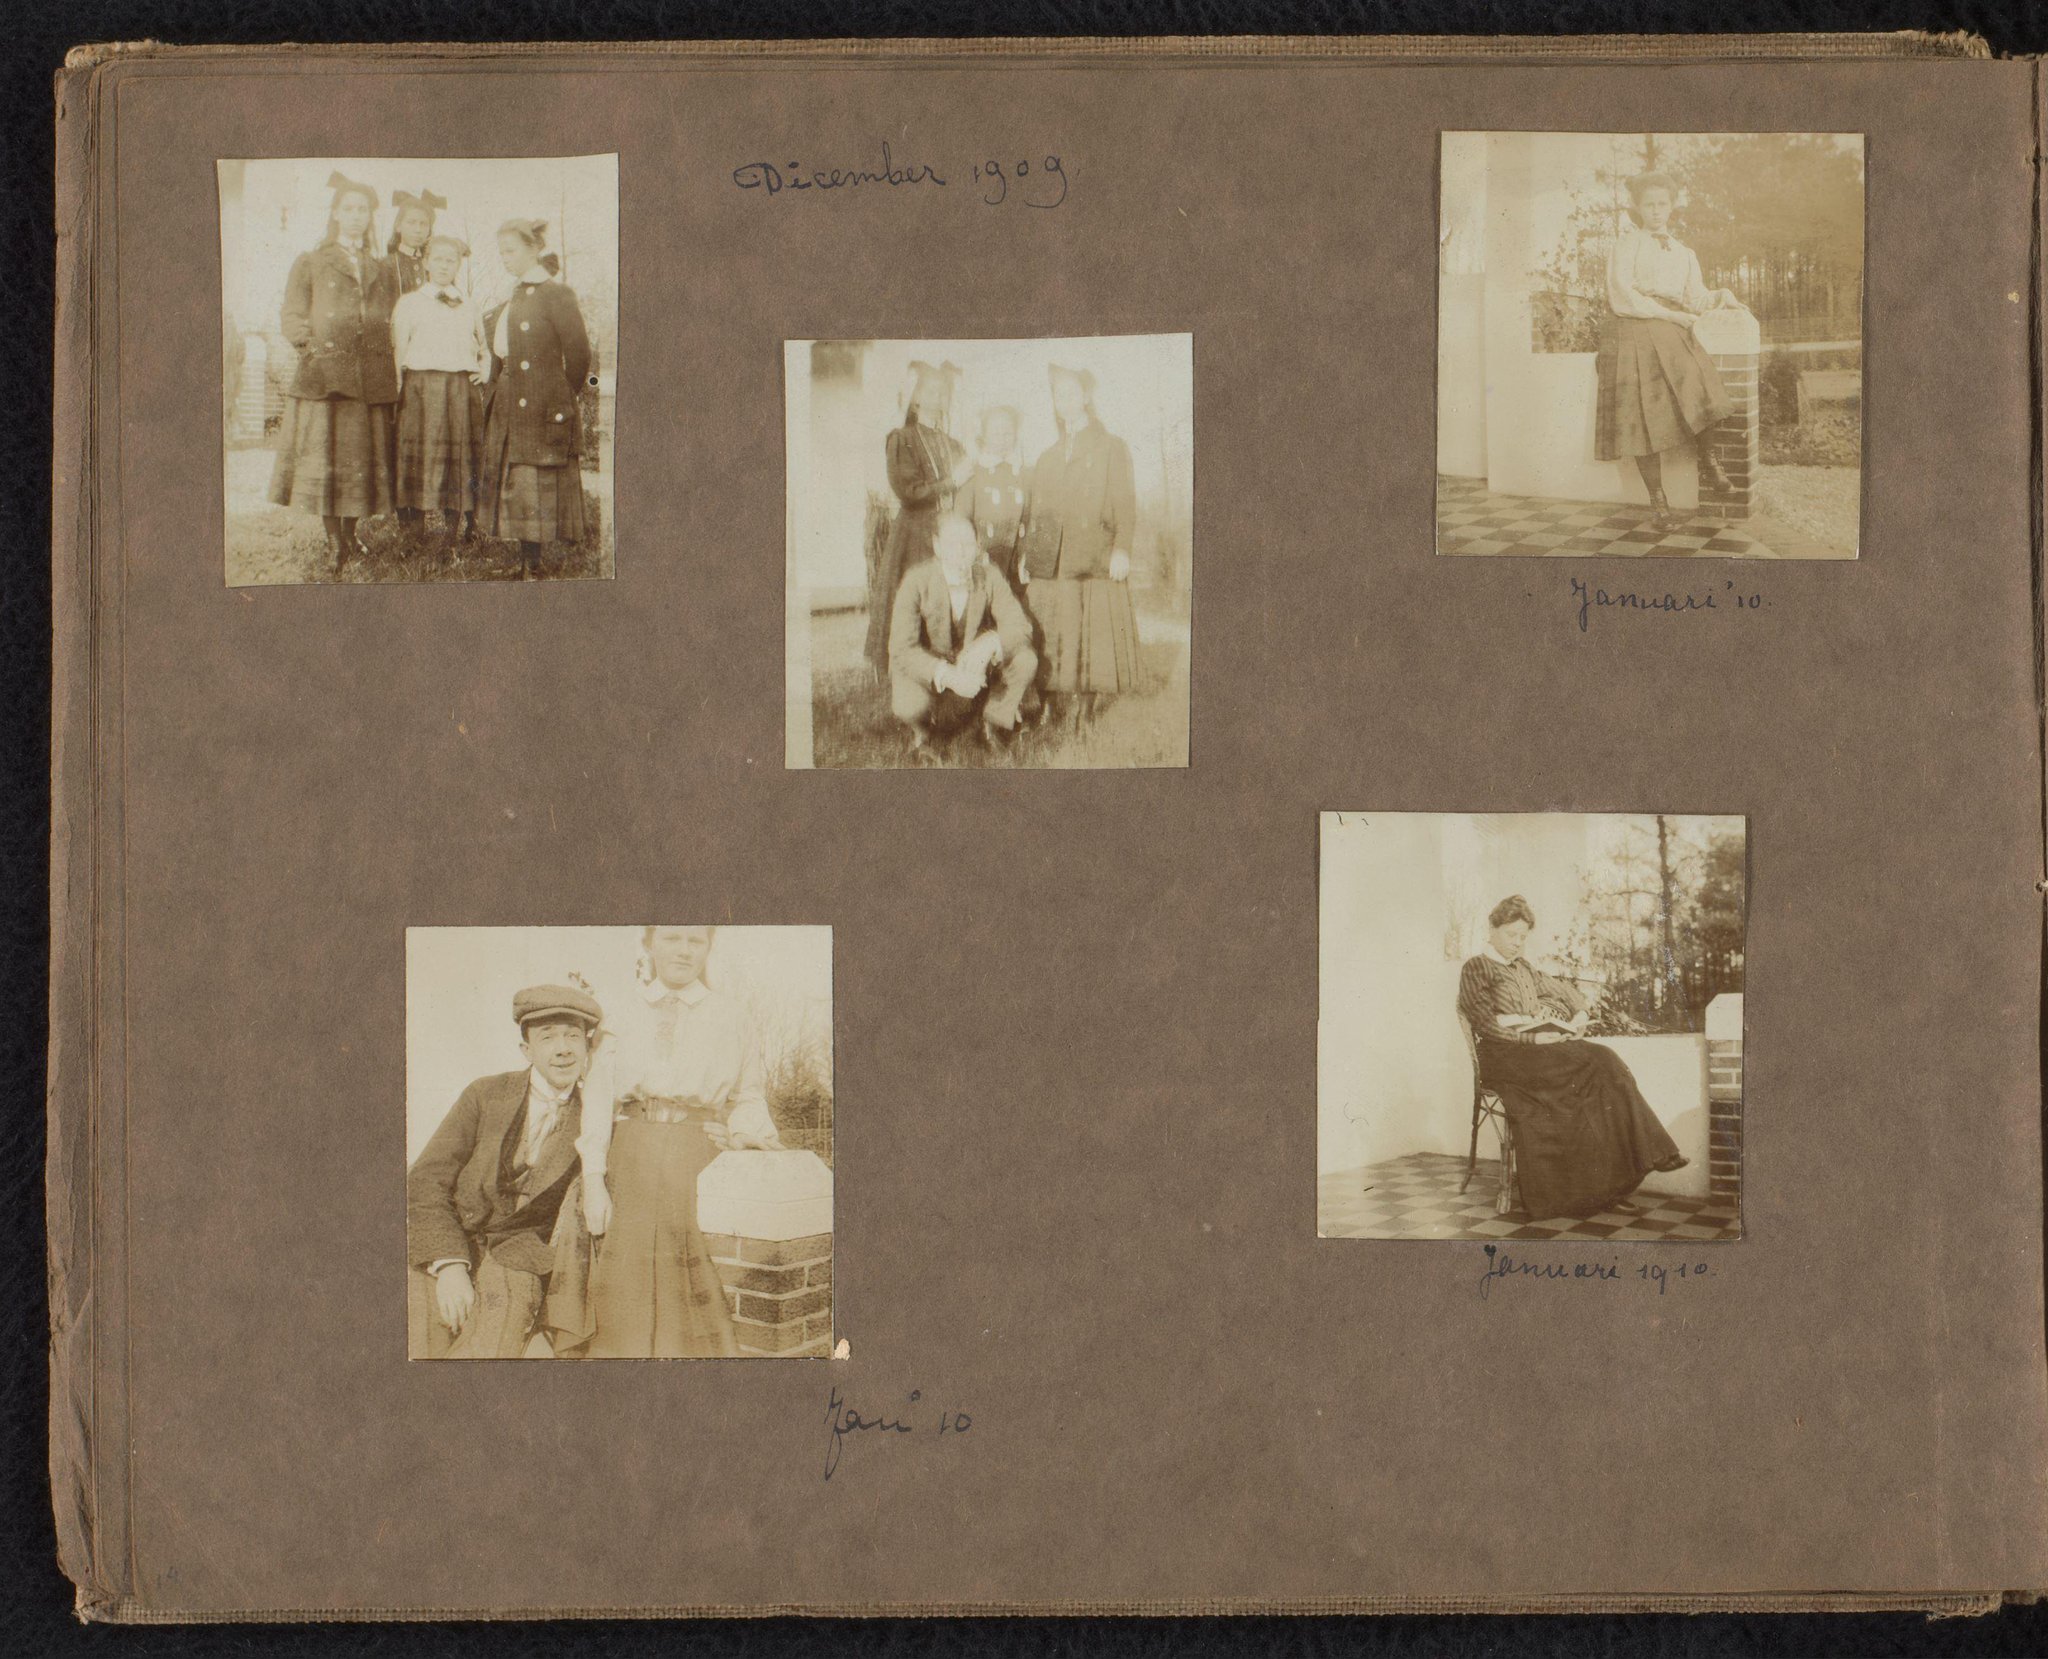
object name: photograph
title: Vijf foto's van de familie Onnen met vrienden, Hilversum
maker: carolina frederika onnen (lien/loen)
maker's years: 1896-1983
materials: paper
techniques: gelatin silver print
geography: hilversum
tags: amsterdam, carolina frederika onnen (lien/loen), friends, historical persons not known by name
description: Deze foto's maken deel uit van een album.